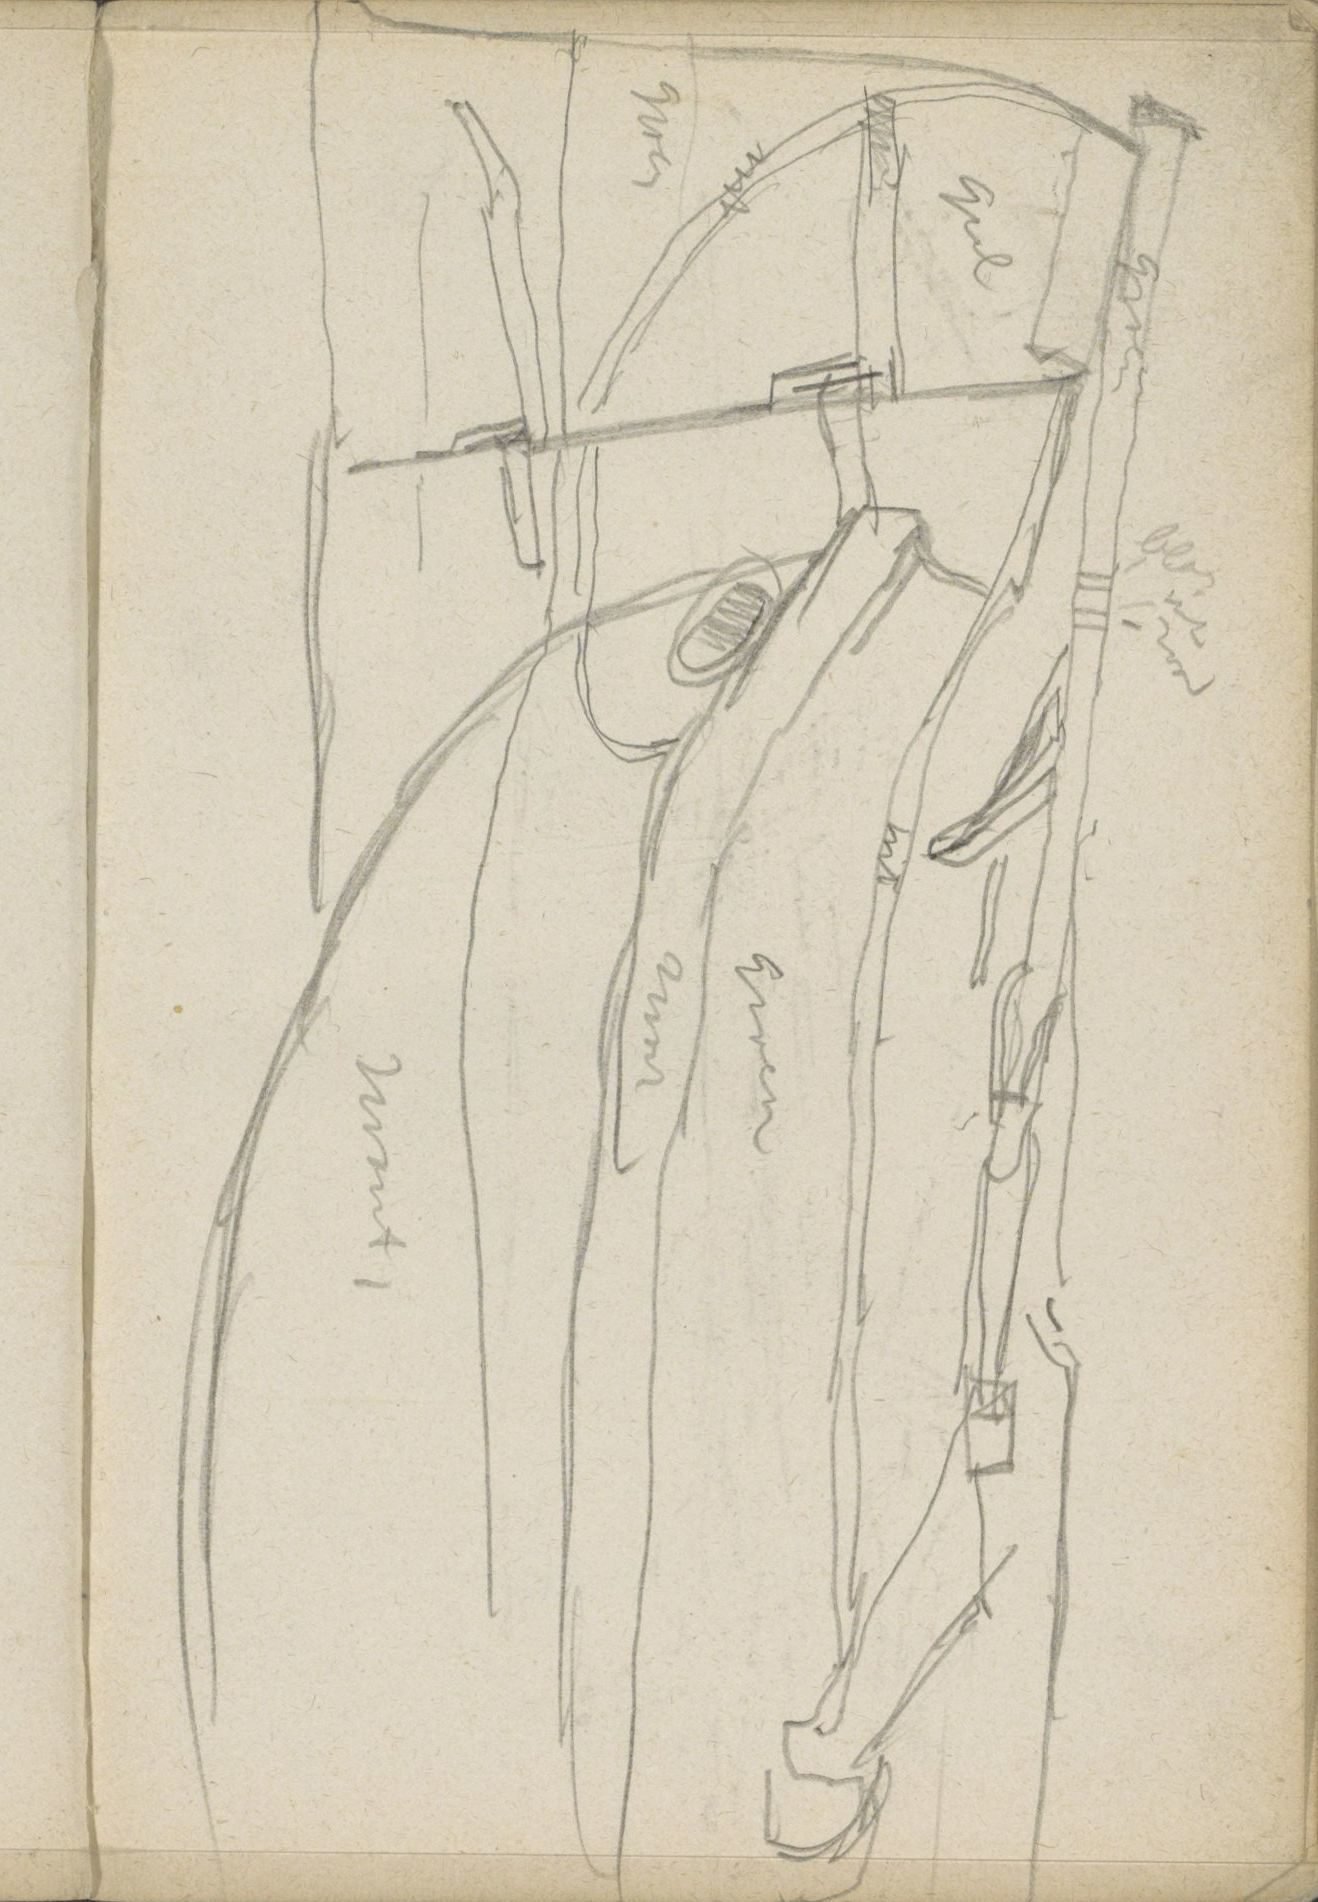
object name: sketchbook leaf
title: Twee boten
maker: george hendrik breitner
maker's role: draughtsman, painter, print maker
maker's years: 1857-1923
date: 1900-1901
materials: paper, pencil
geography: amsterdam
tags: ships (in general)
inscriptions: kleurnotitie, handgeschreven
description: Twee boten. Pagina 48 uit een schetsboek met 46 bladen vervaardigd te Amsterdam.